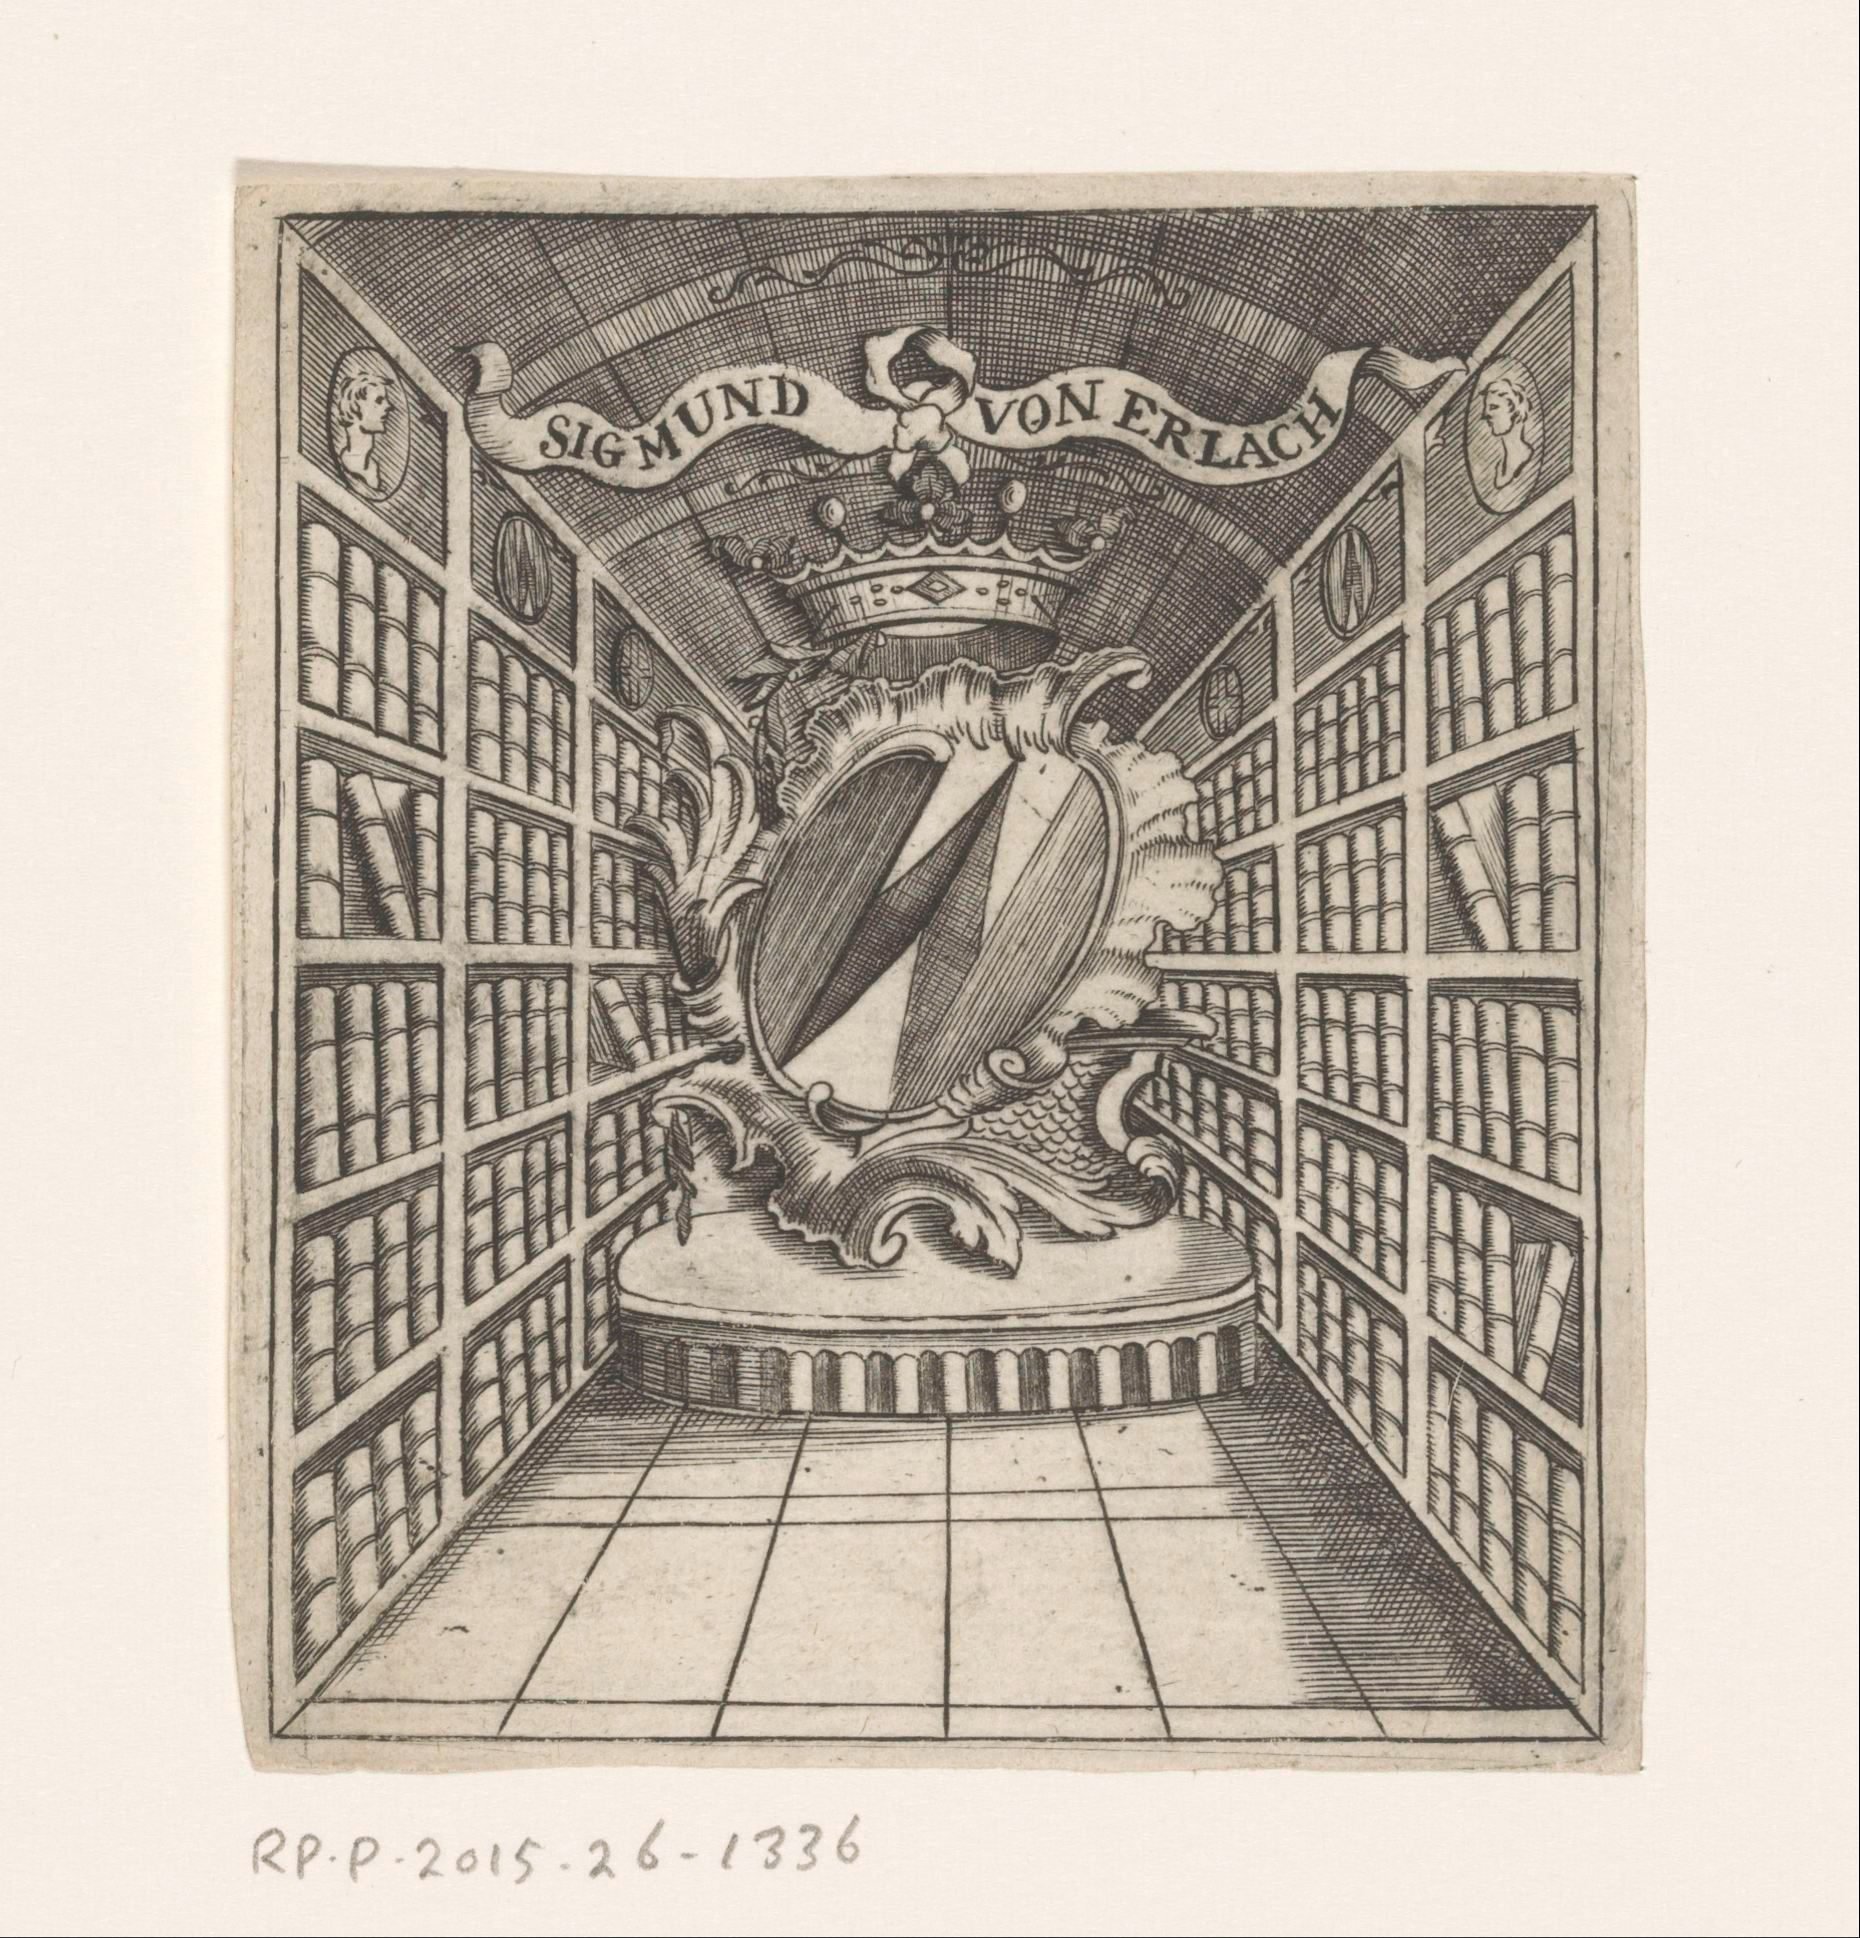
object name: bookplate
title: Ex libris van Sigmund von Erlach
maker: Anonymous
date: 1700-1799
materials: paper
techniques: engraving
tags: bookshelves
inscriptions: collector's mark: Lugt 2228, collector's mark: Lugt 4780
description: Bibliotheek met in het midden het wapen van Sigmund von Erlach op een verhoging.